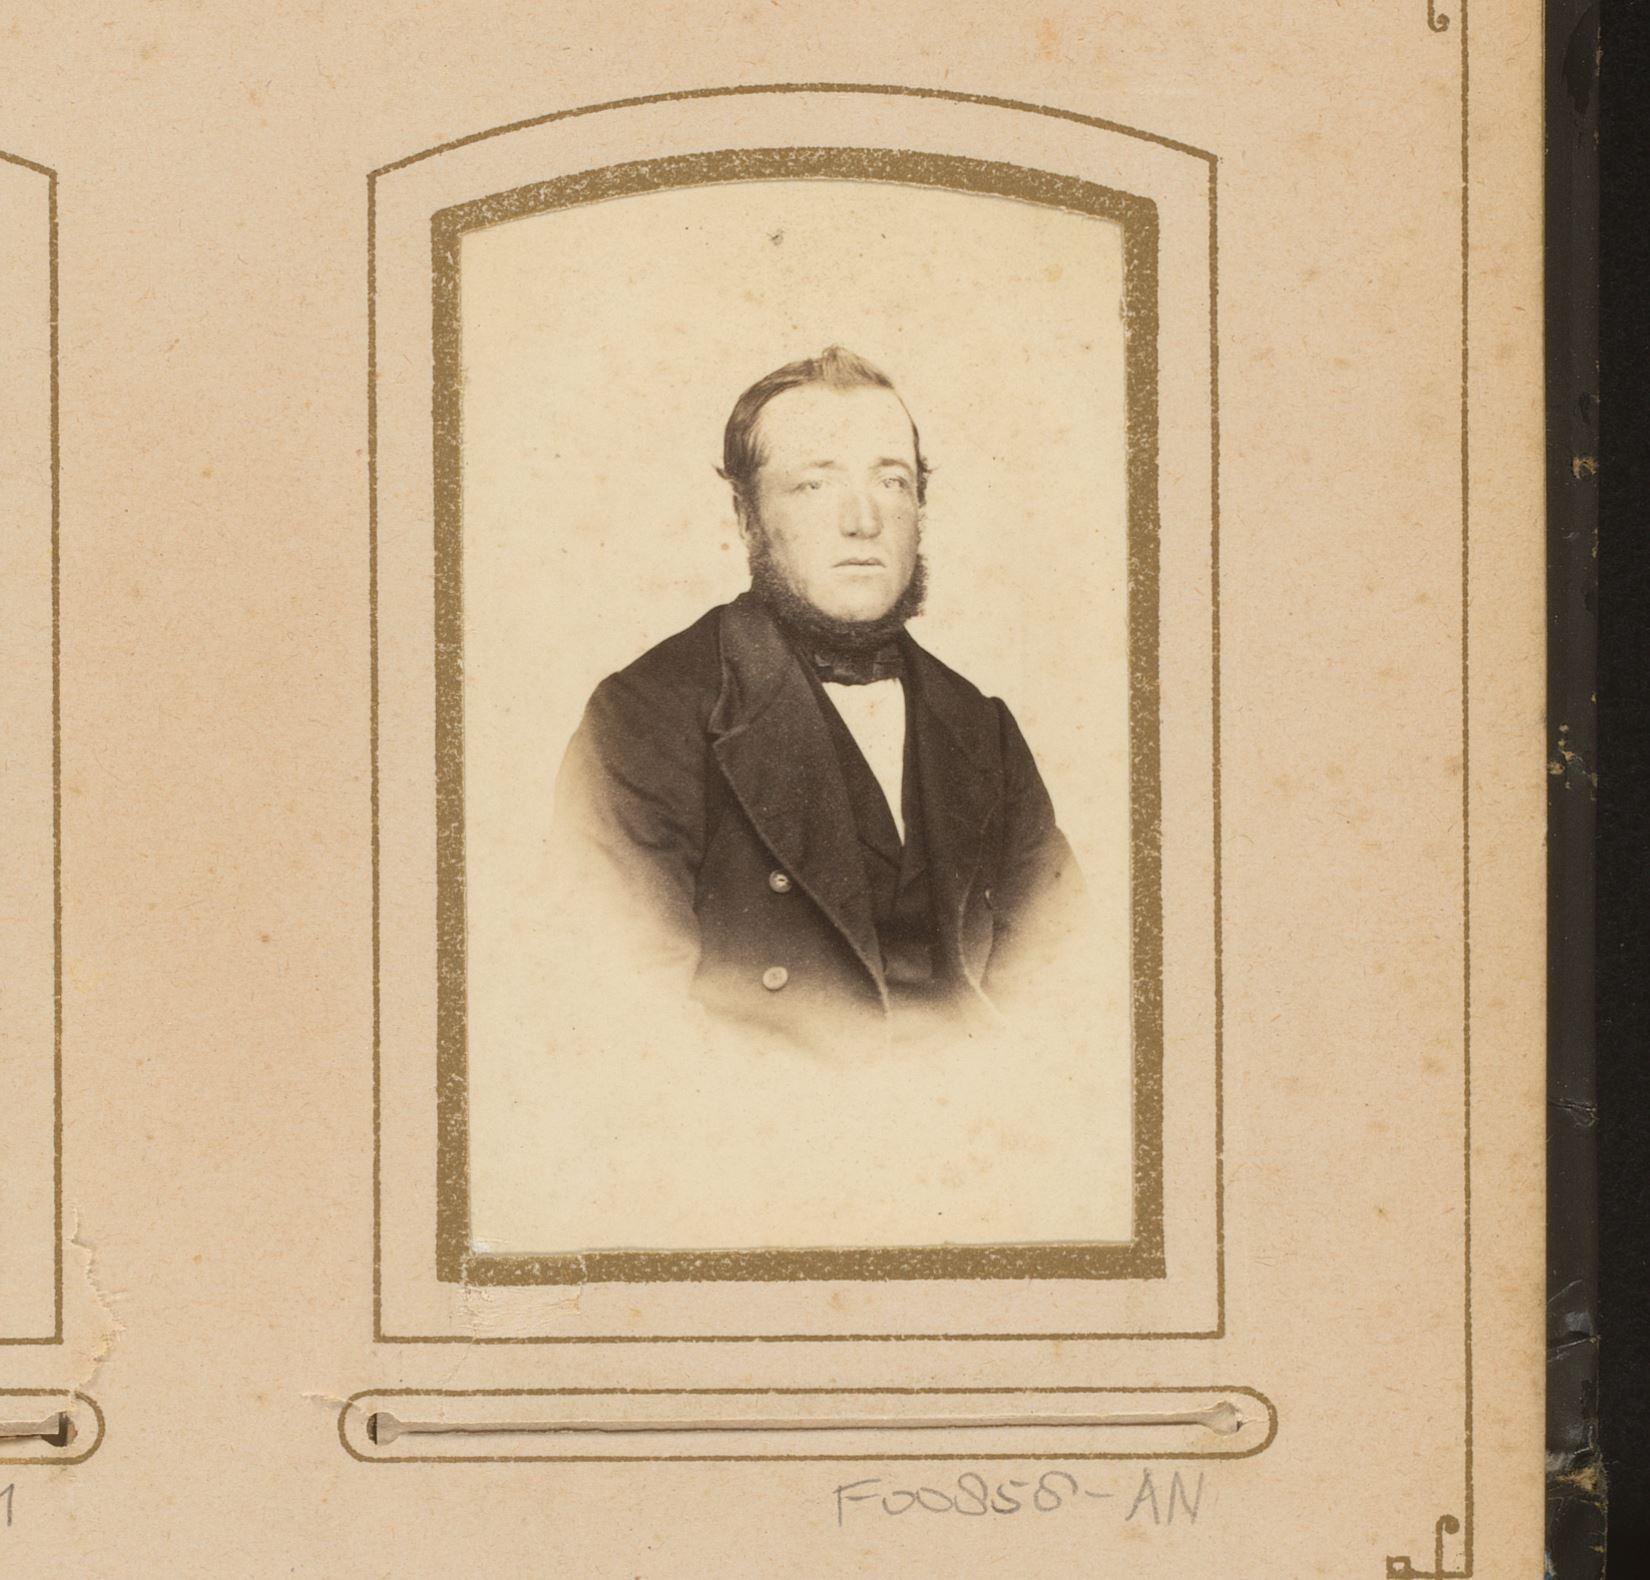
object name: photograph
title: Portret van een man met baard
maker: Anonymous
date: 1860-1890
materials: cardboard, photographic support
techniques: albumen print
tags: historical persons, beard